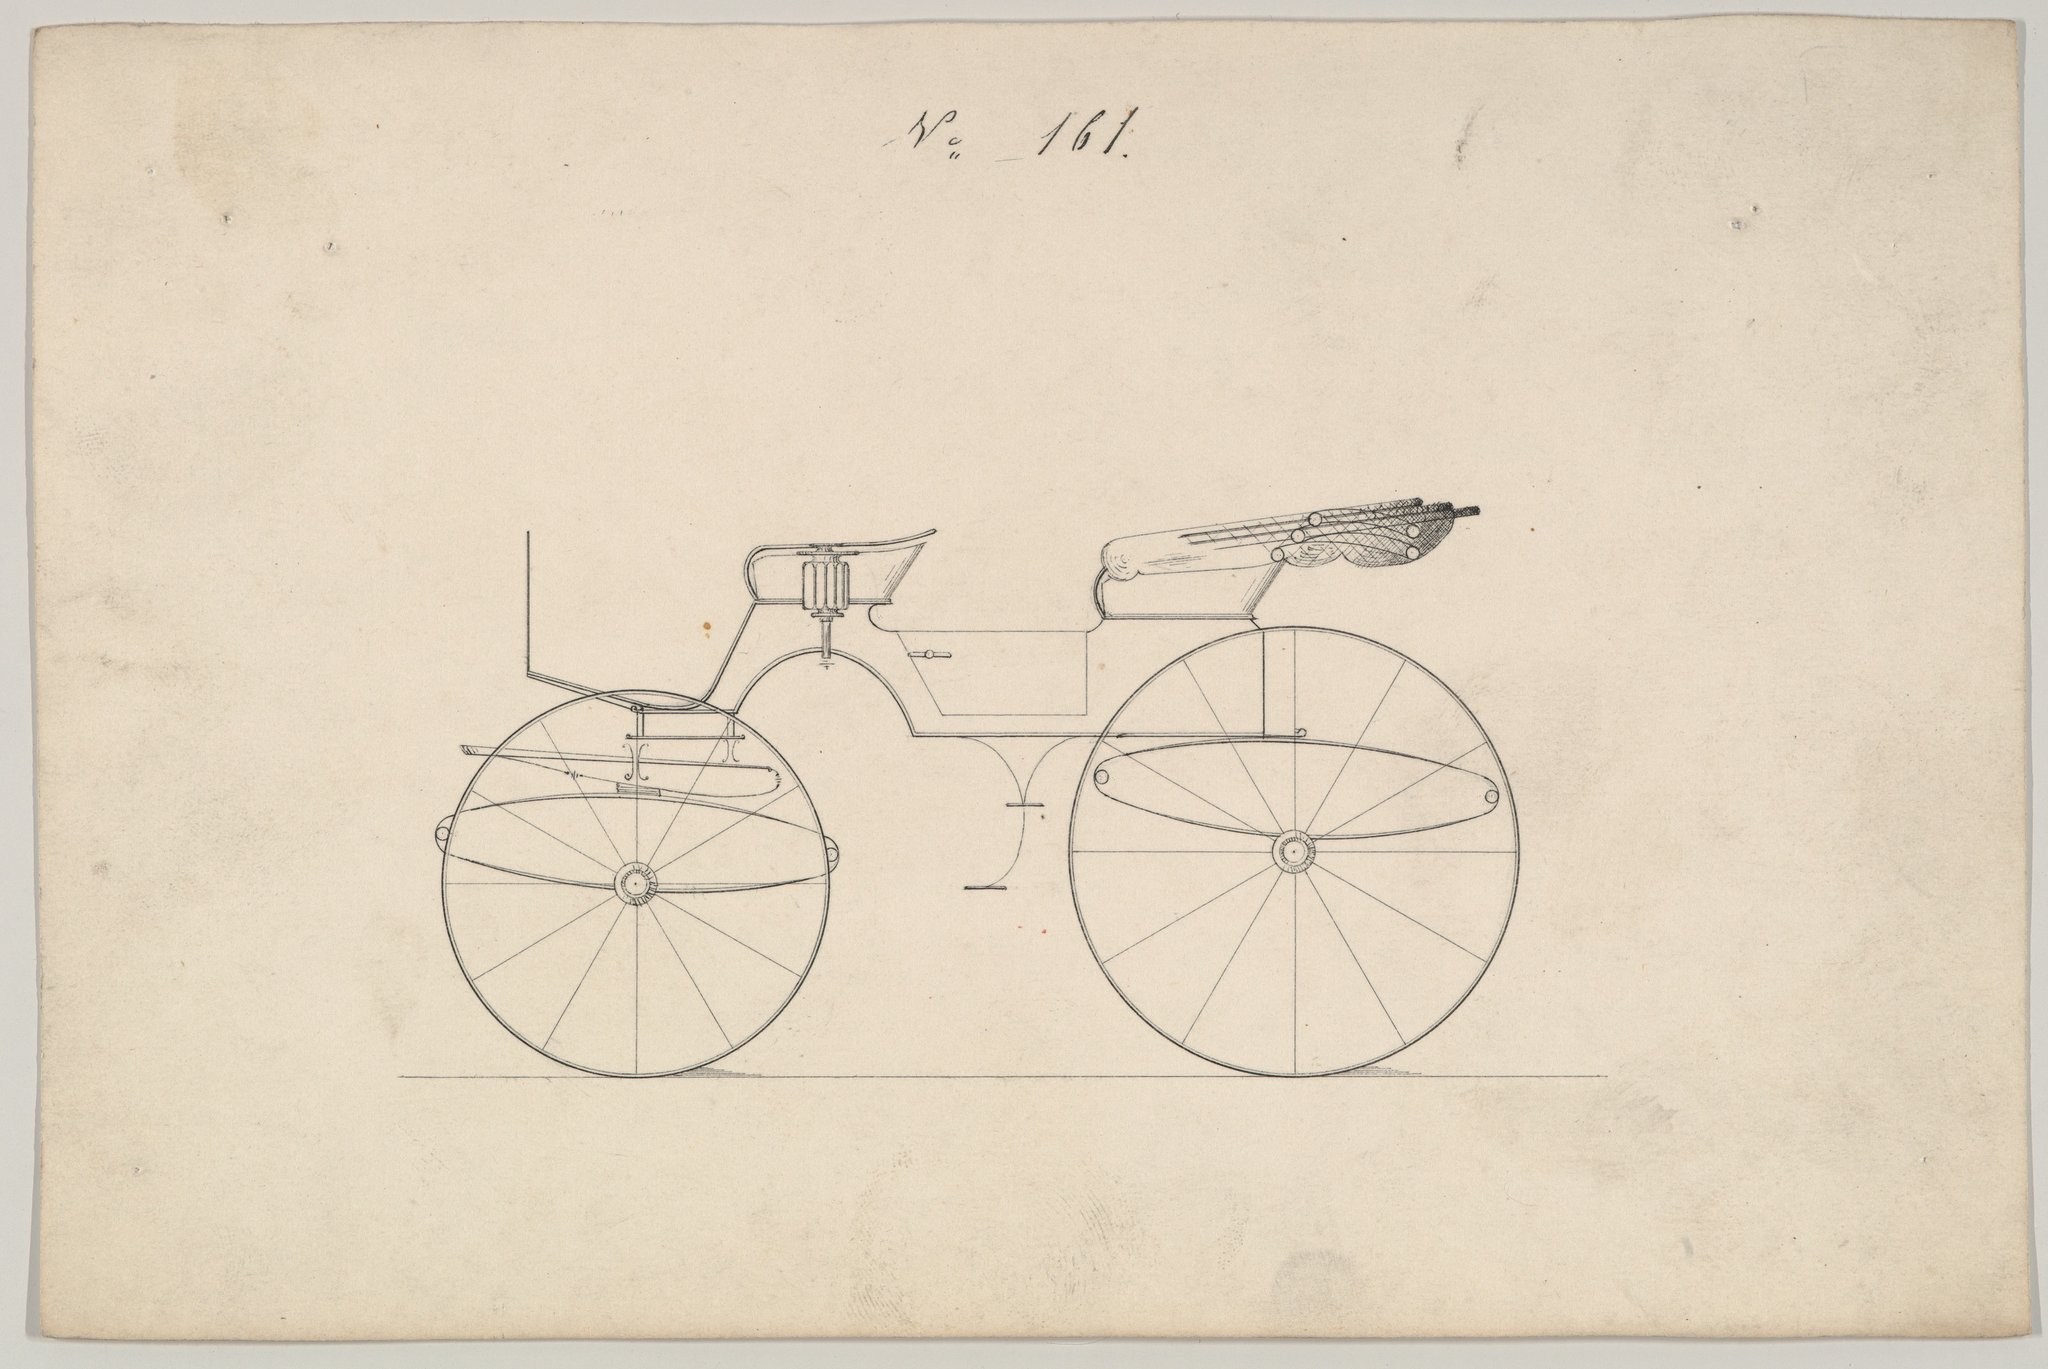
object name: drawing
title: Design for Phaeton, no. 161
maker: brewster & co.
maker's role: manufacturer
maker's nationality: american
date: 1850-1874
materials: ink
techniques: pen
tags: carriages